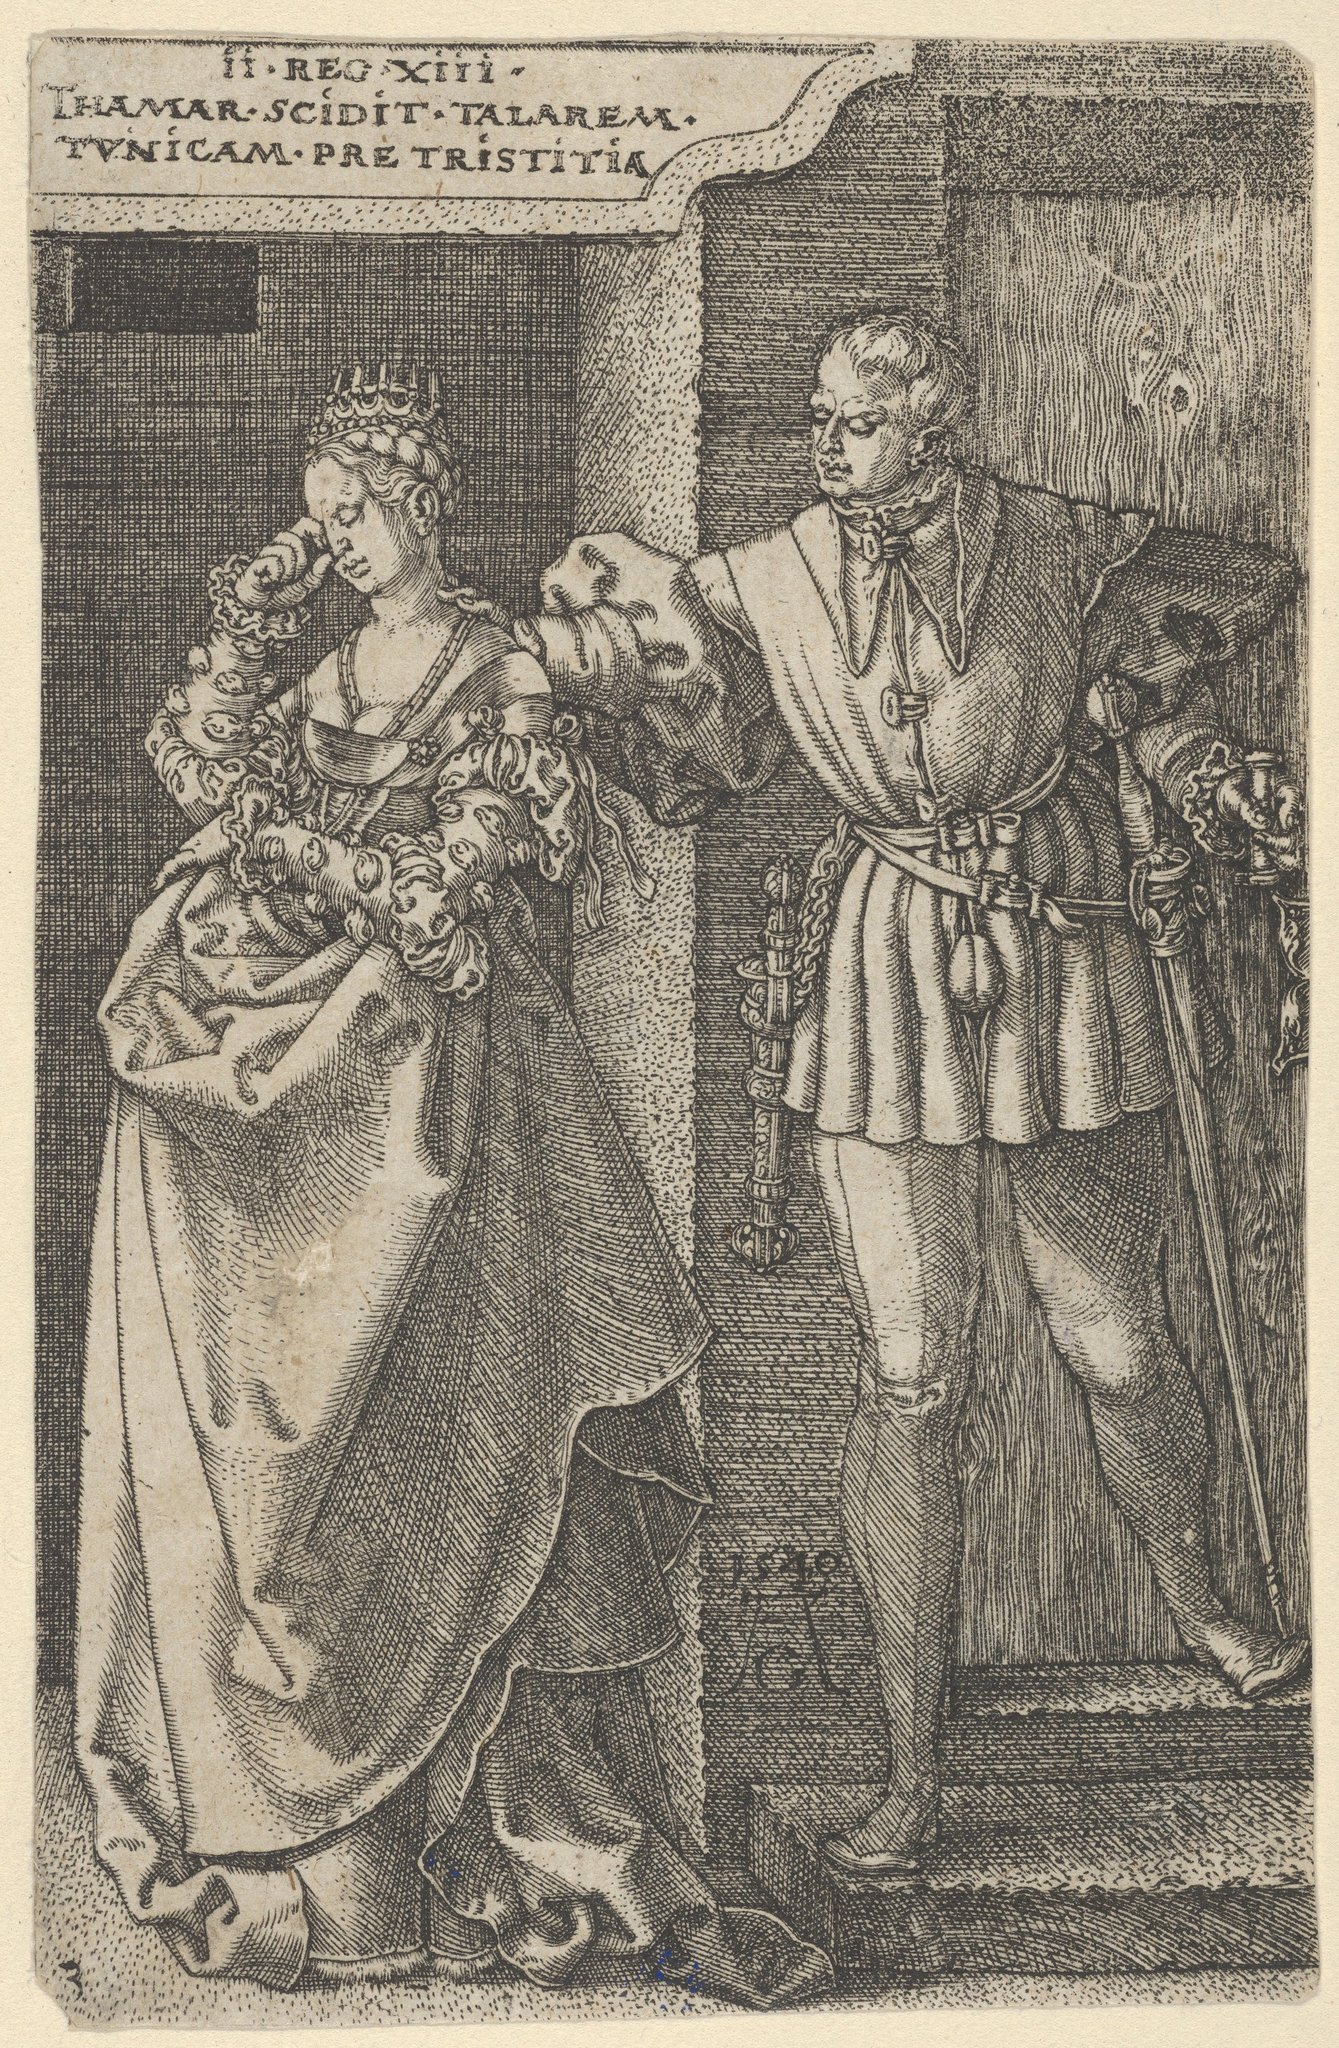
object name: print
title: Tamar Turned Out of Amnon's House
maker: heinrich aldegrever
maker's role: artist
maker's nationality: german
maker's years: 1502-1561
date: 1540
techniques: engraving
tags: men,women